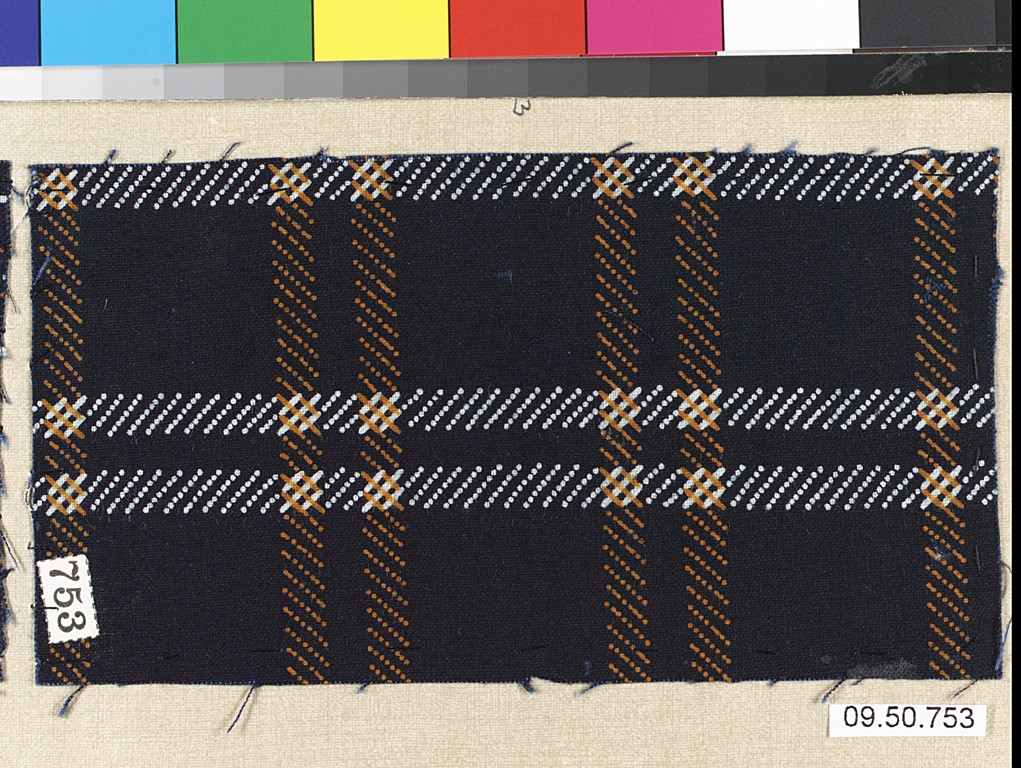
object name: piece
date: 1801-1900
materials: cotton